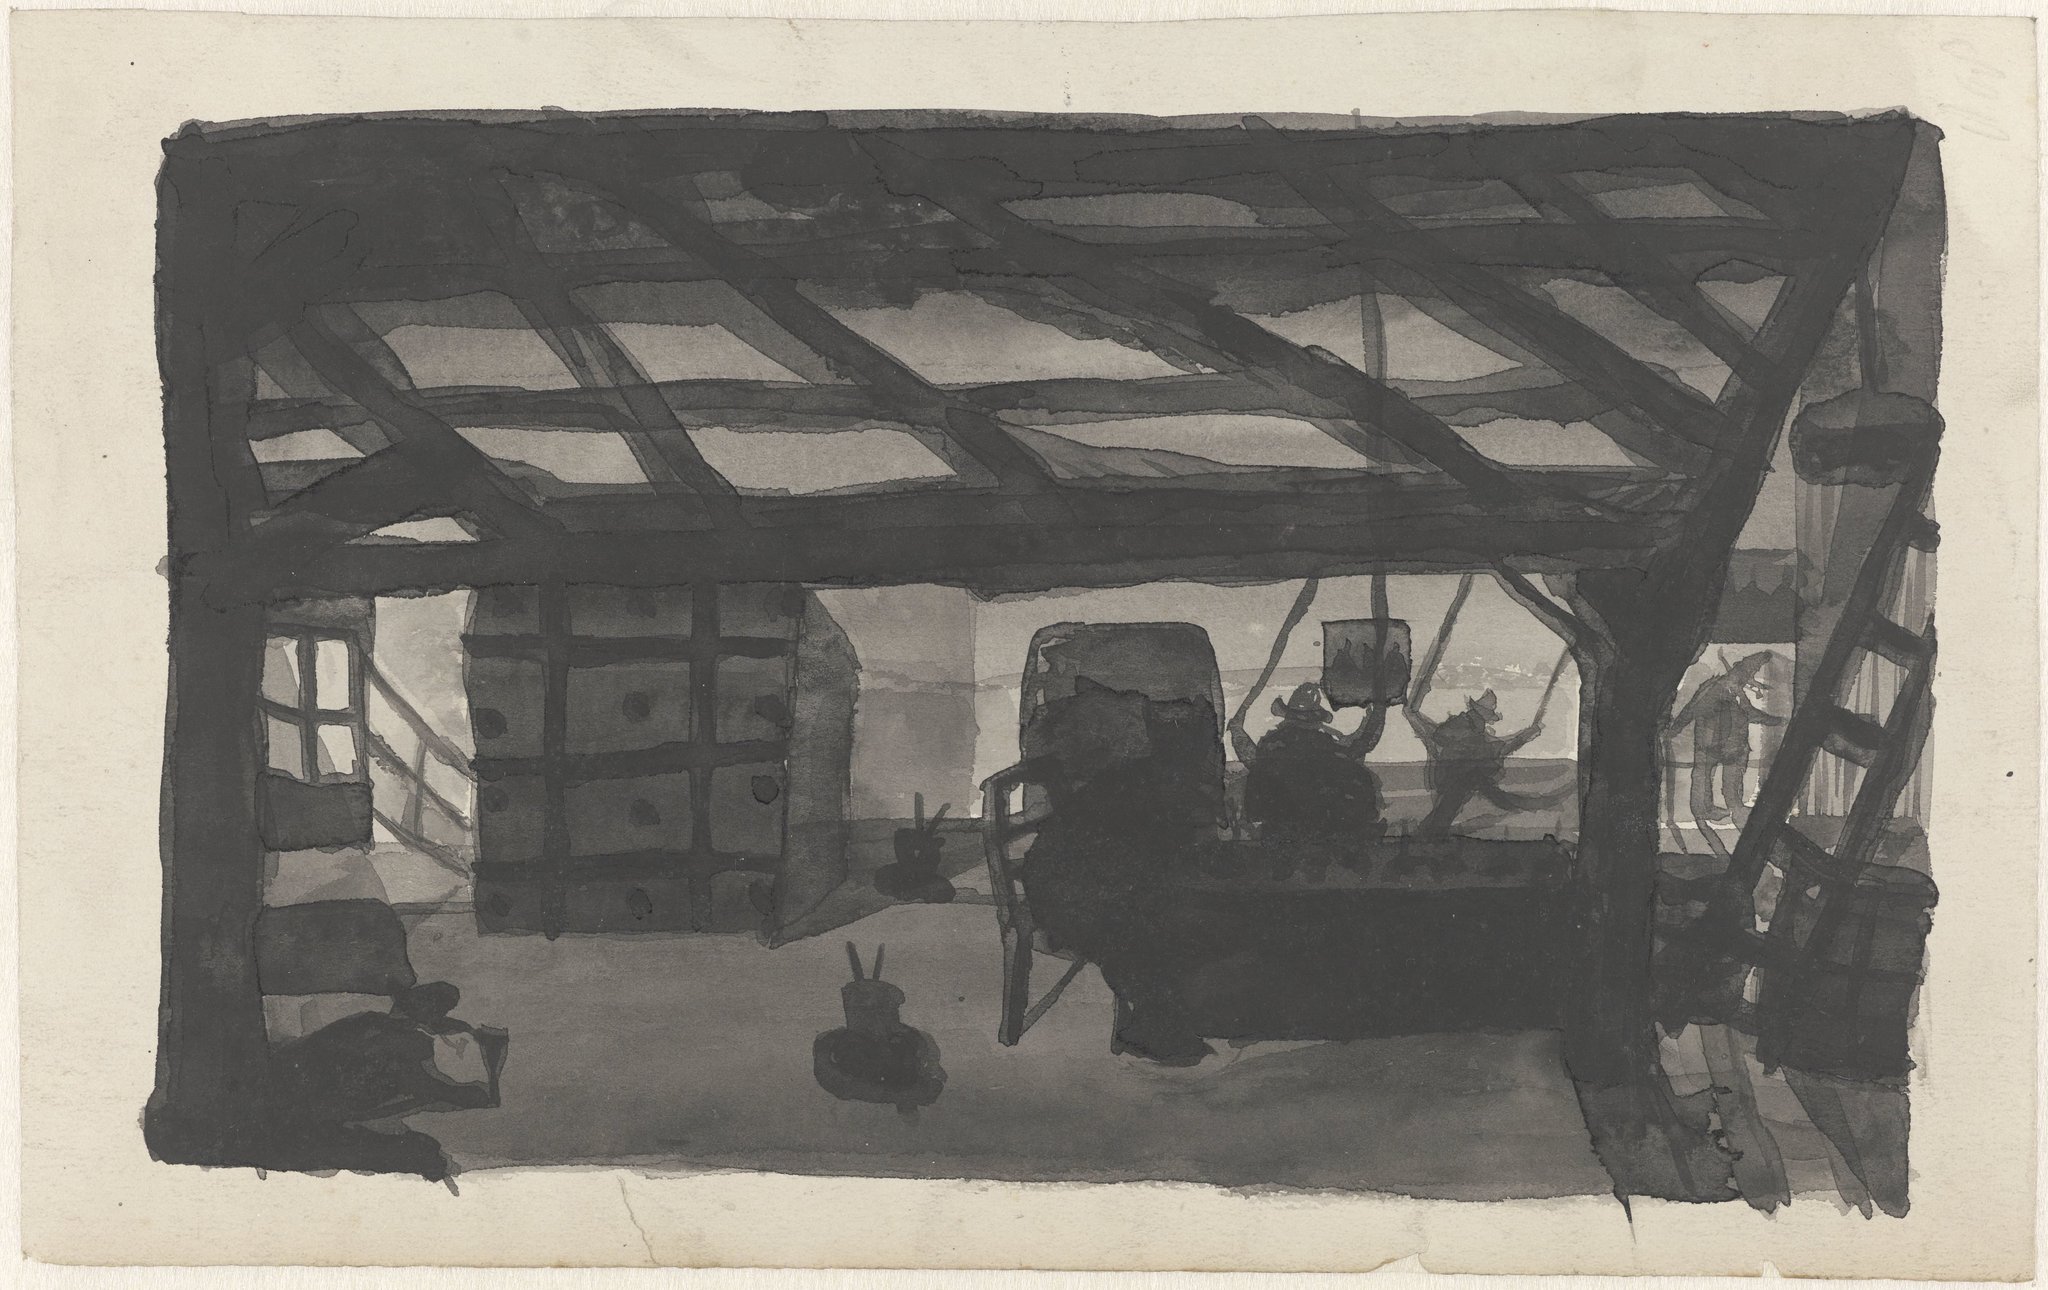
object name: drawing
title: Zolderkamer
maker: george washington schwartze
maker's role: draughtsman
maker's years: 1857-1909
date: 1867-1909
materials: paper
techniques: brush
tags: attic, loft